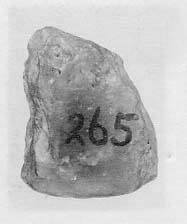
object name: knife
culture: north american, alaskan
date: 1902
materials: jade